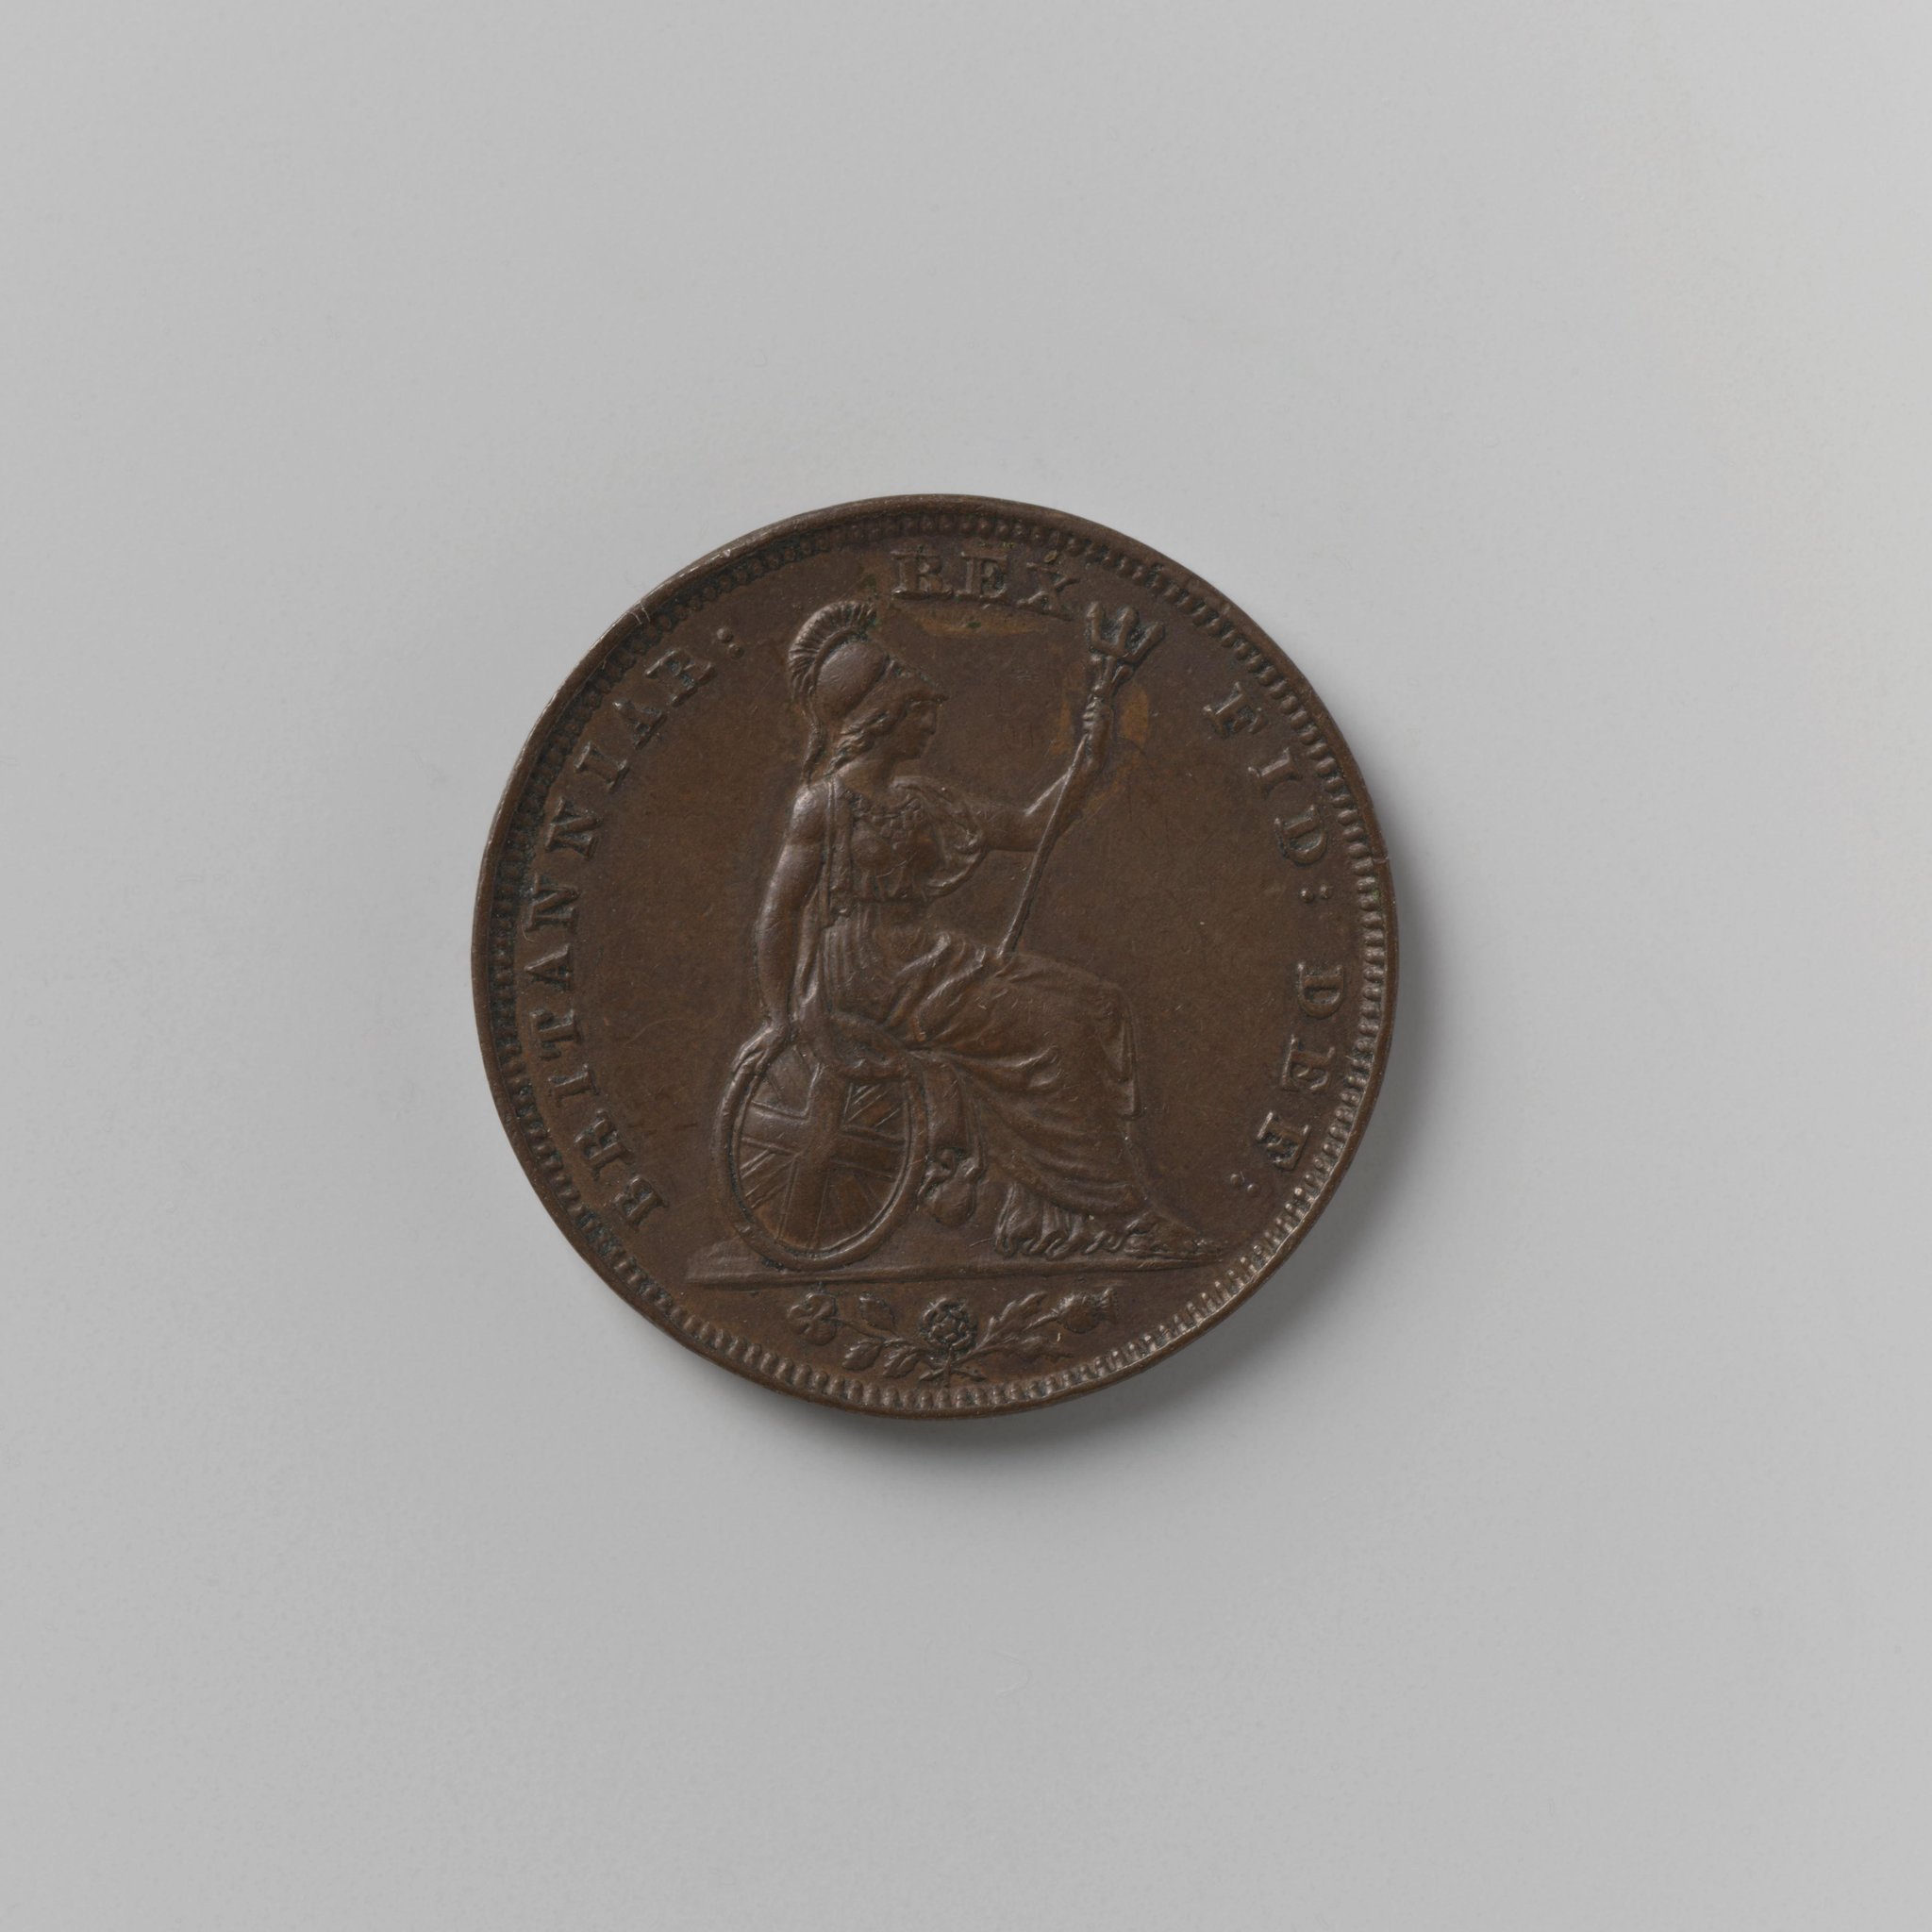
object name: coin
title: Farthing uit Engeland van William IV, 1834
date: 1834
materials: copper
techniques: striking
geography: london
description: Koperen munt. Voorzijde: hoofd van de koning naar rechts. Jaartal onderaan. Keerzijde: tegen wapenschild gezeten Brittannia met drietand, naar rechts. In afsnede klaverblad, roos en distel. Gladde rand.